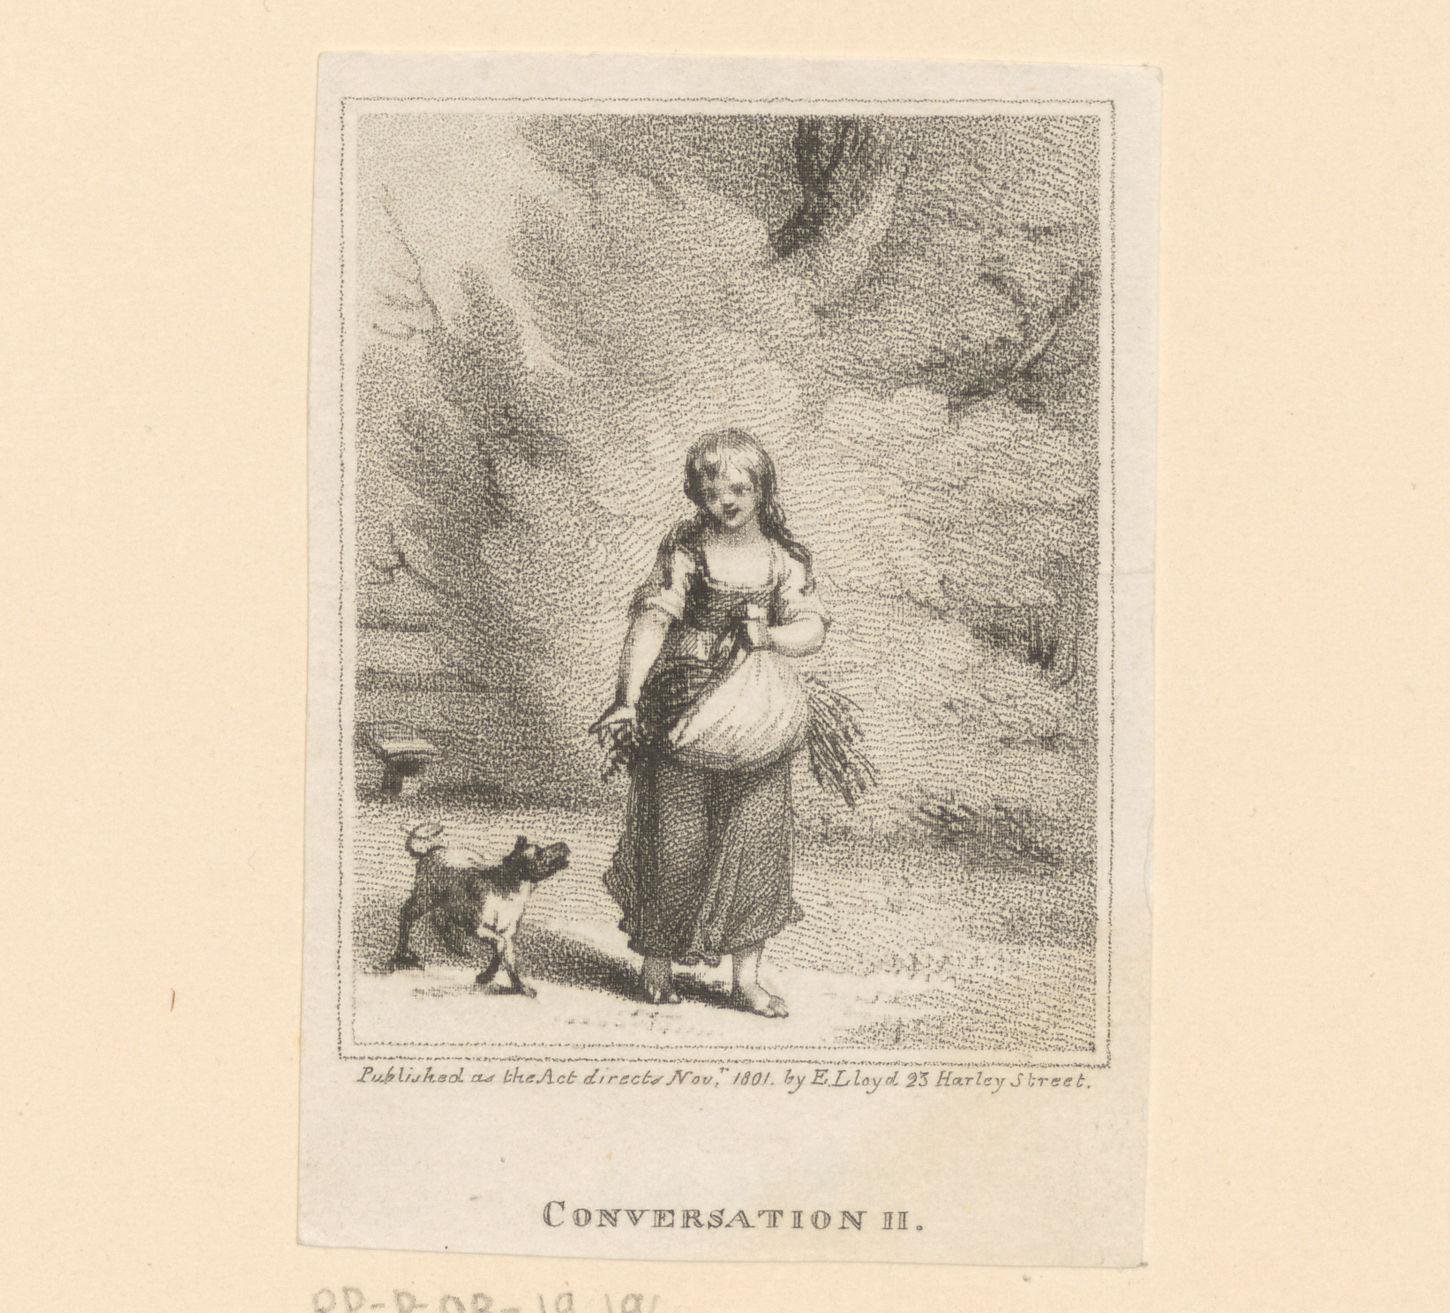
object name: print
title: Conversation II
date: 1801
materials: paper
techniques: etching, soft ground etching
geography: london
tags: tasks performed by children - aa - girl, taming, domestication of animals; tamed or domesticated animal, dog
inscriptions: collector's mark: Lugt 2228